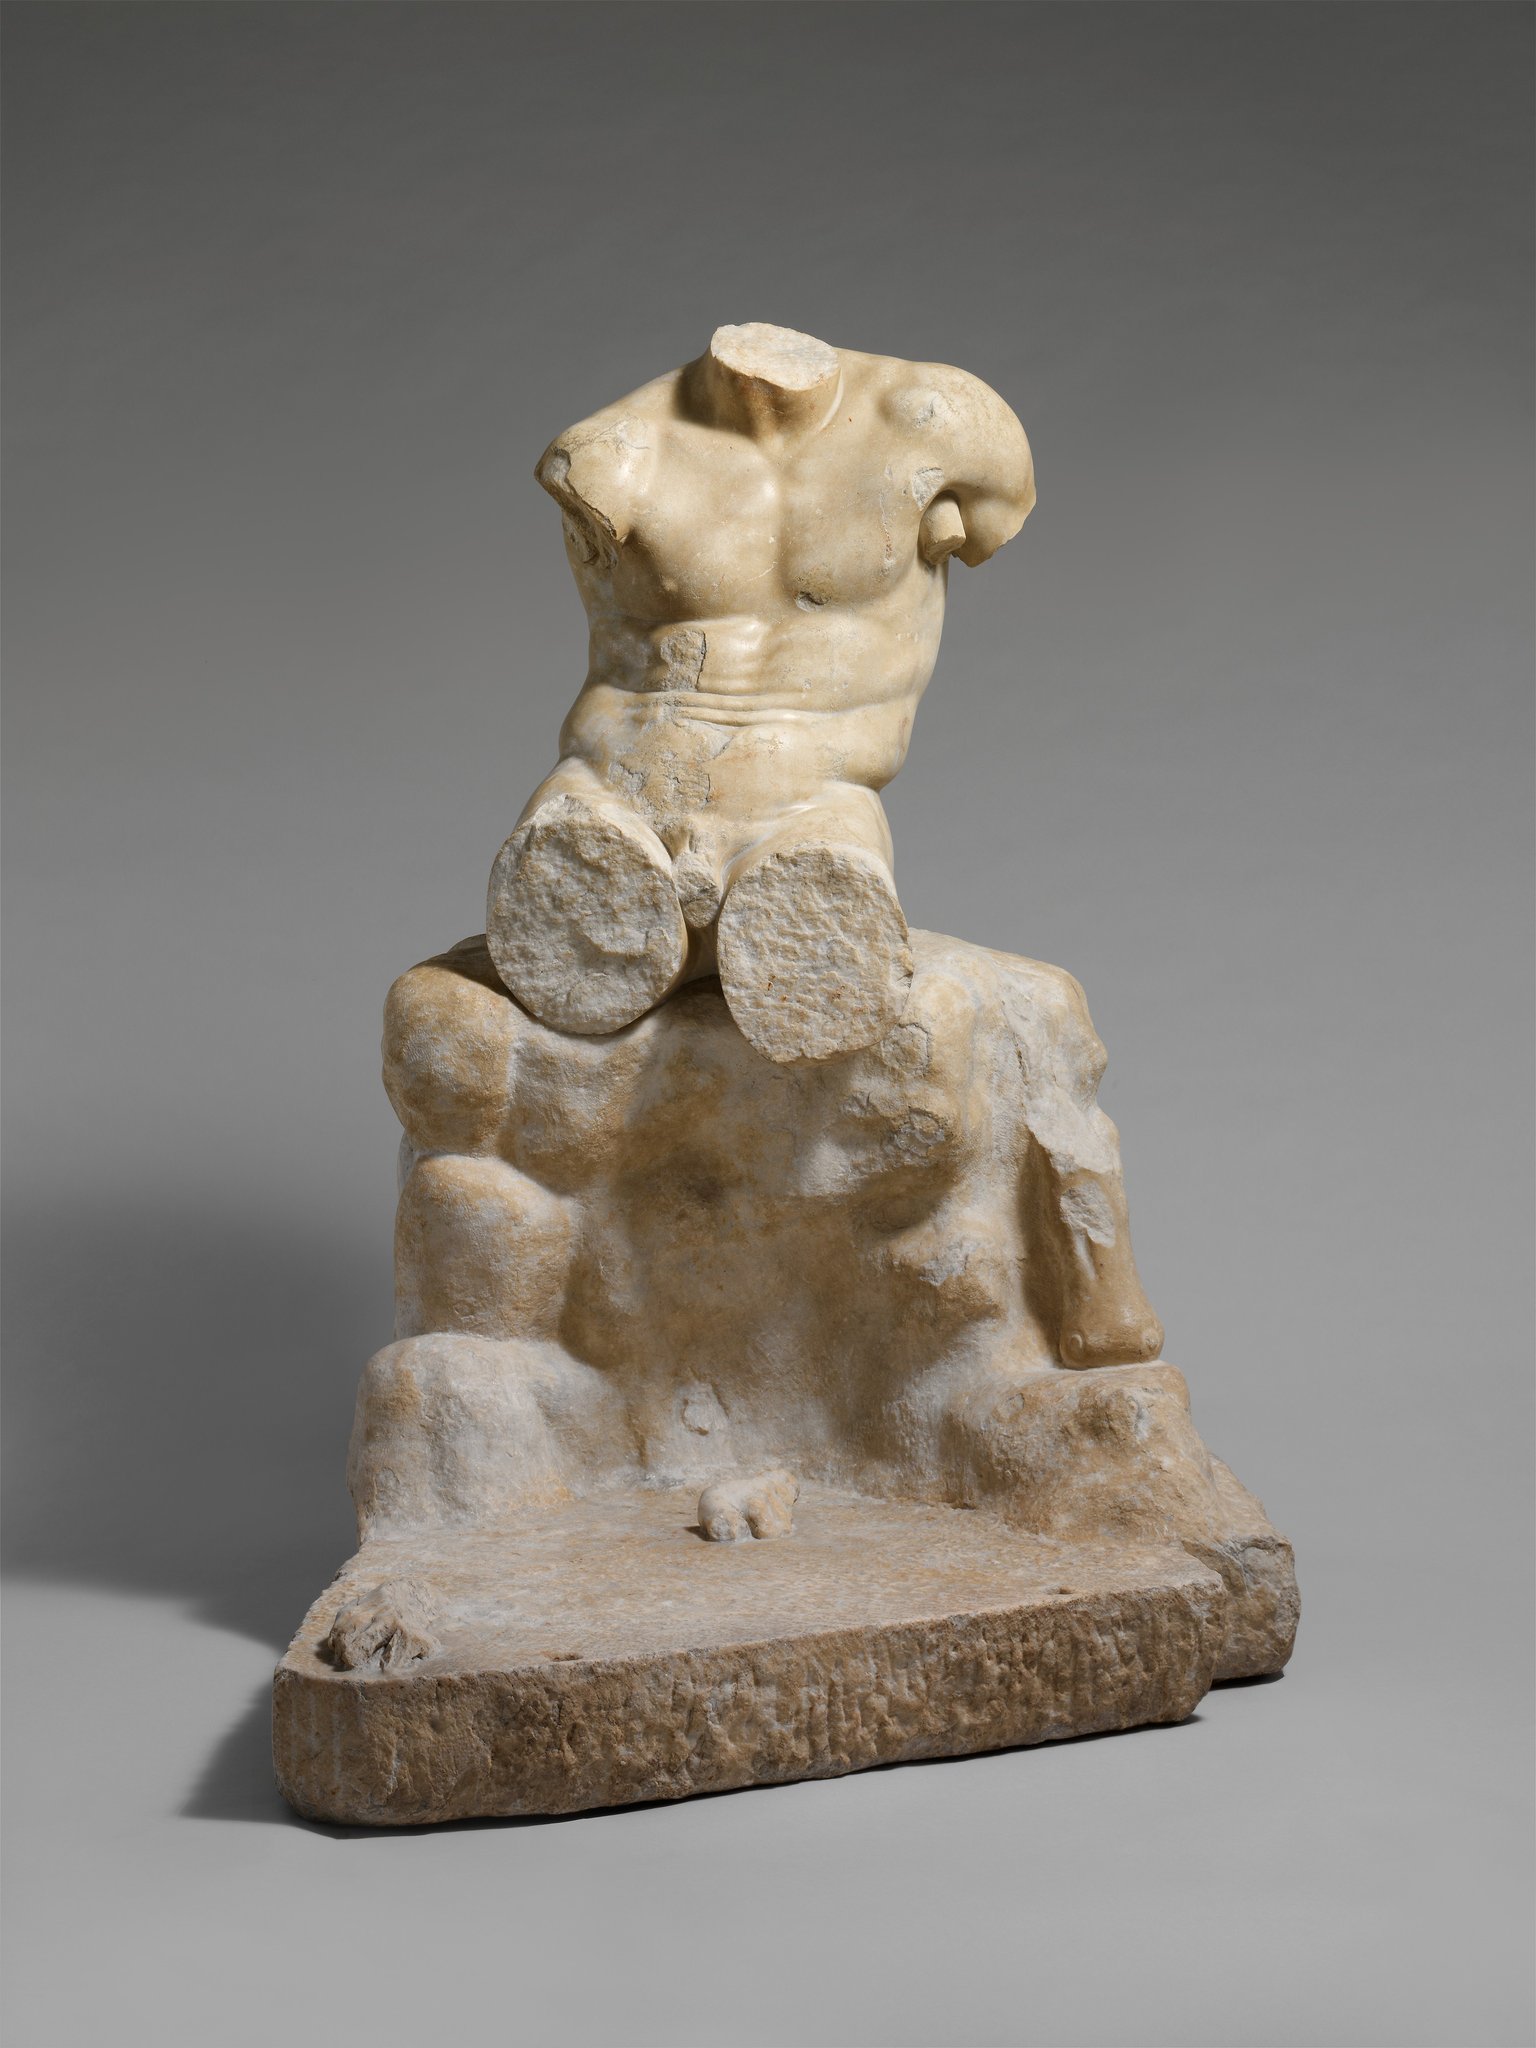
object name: torso of herakles, seated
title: Marble statue of Herakles seated on a rock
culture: roman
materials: marble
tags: male nudes,herakles